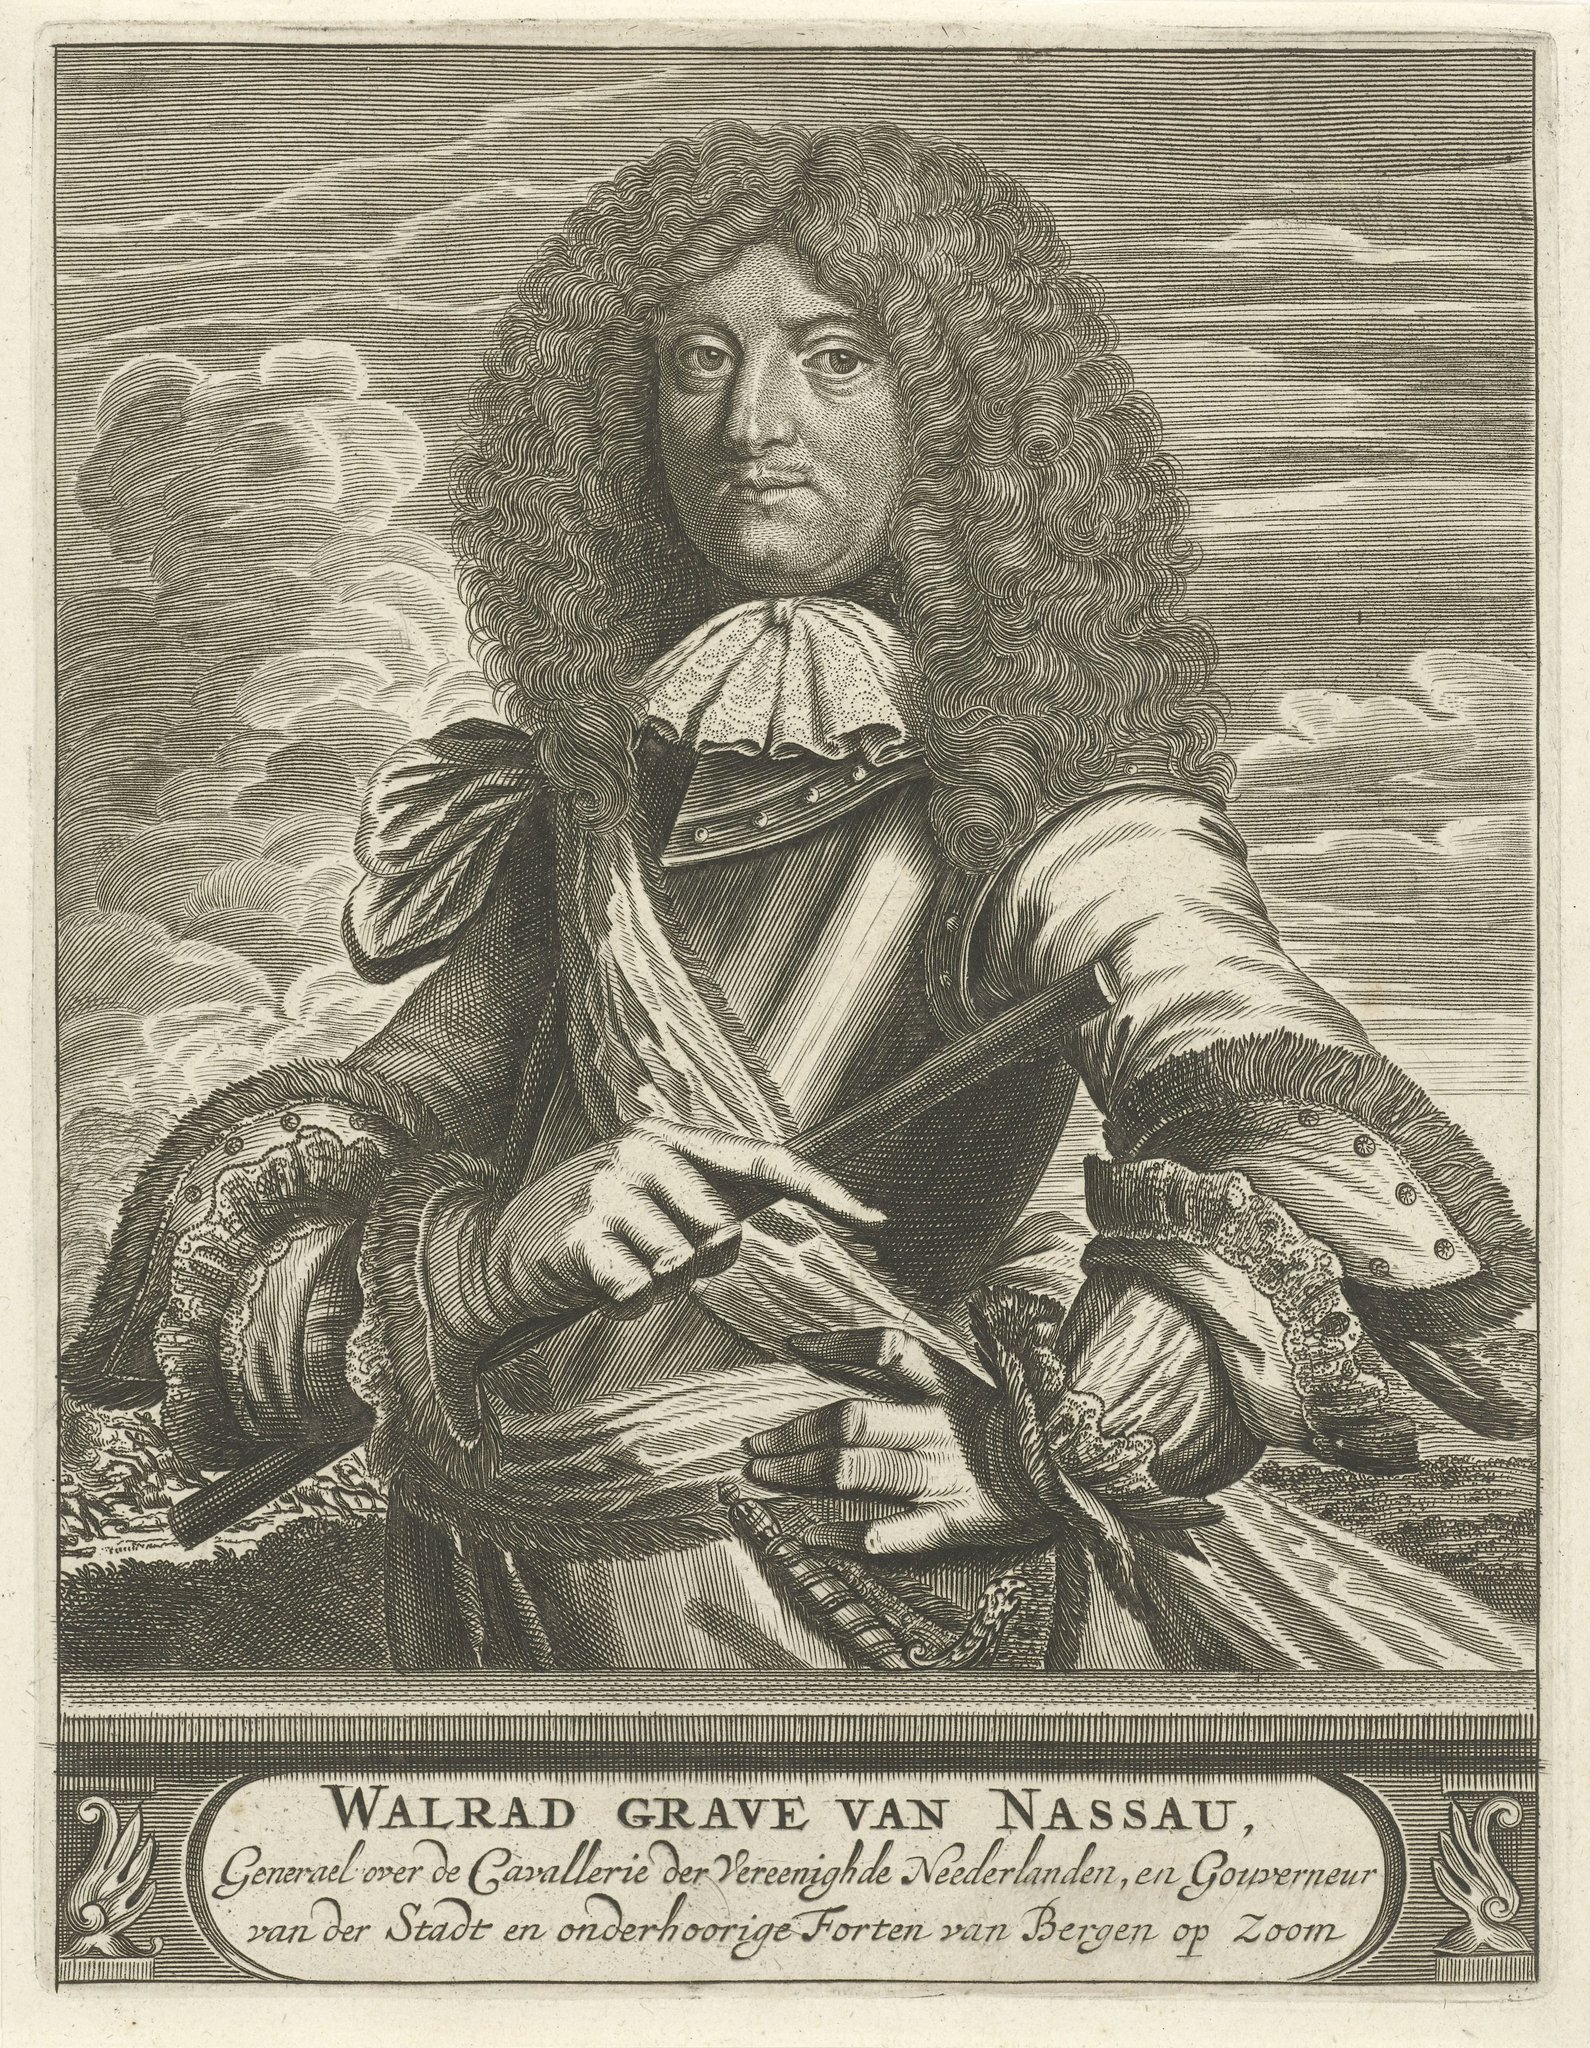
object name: print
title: Portret van Wolrat, graaf van Nassau-Usingen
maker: christiaan hagen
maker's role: draughtsman, print maker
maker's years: 1635-1707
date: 1663-1695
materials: paper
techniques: engraving, etching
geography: amsterdam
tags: earl, gloves, mittens, etc., belt, girdle, waistband, armour, battle, shoulder-belt, bandoleer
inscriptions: collector's mark: Lugt 2228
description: Portret ten halven lijve van Wolrat, graaf van Nassau-Usingen, gekleed in een harnas. In zijn rechterhand houdt hij een commandostaf. Op de achtergrond is een veldslag afgebeeld. Onder zijn portret een plint, waarop zijn naam en titel in drie regels in het Nederlands in een cartouche.